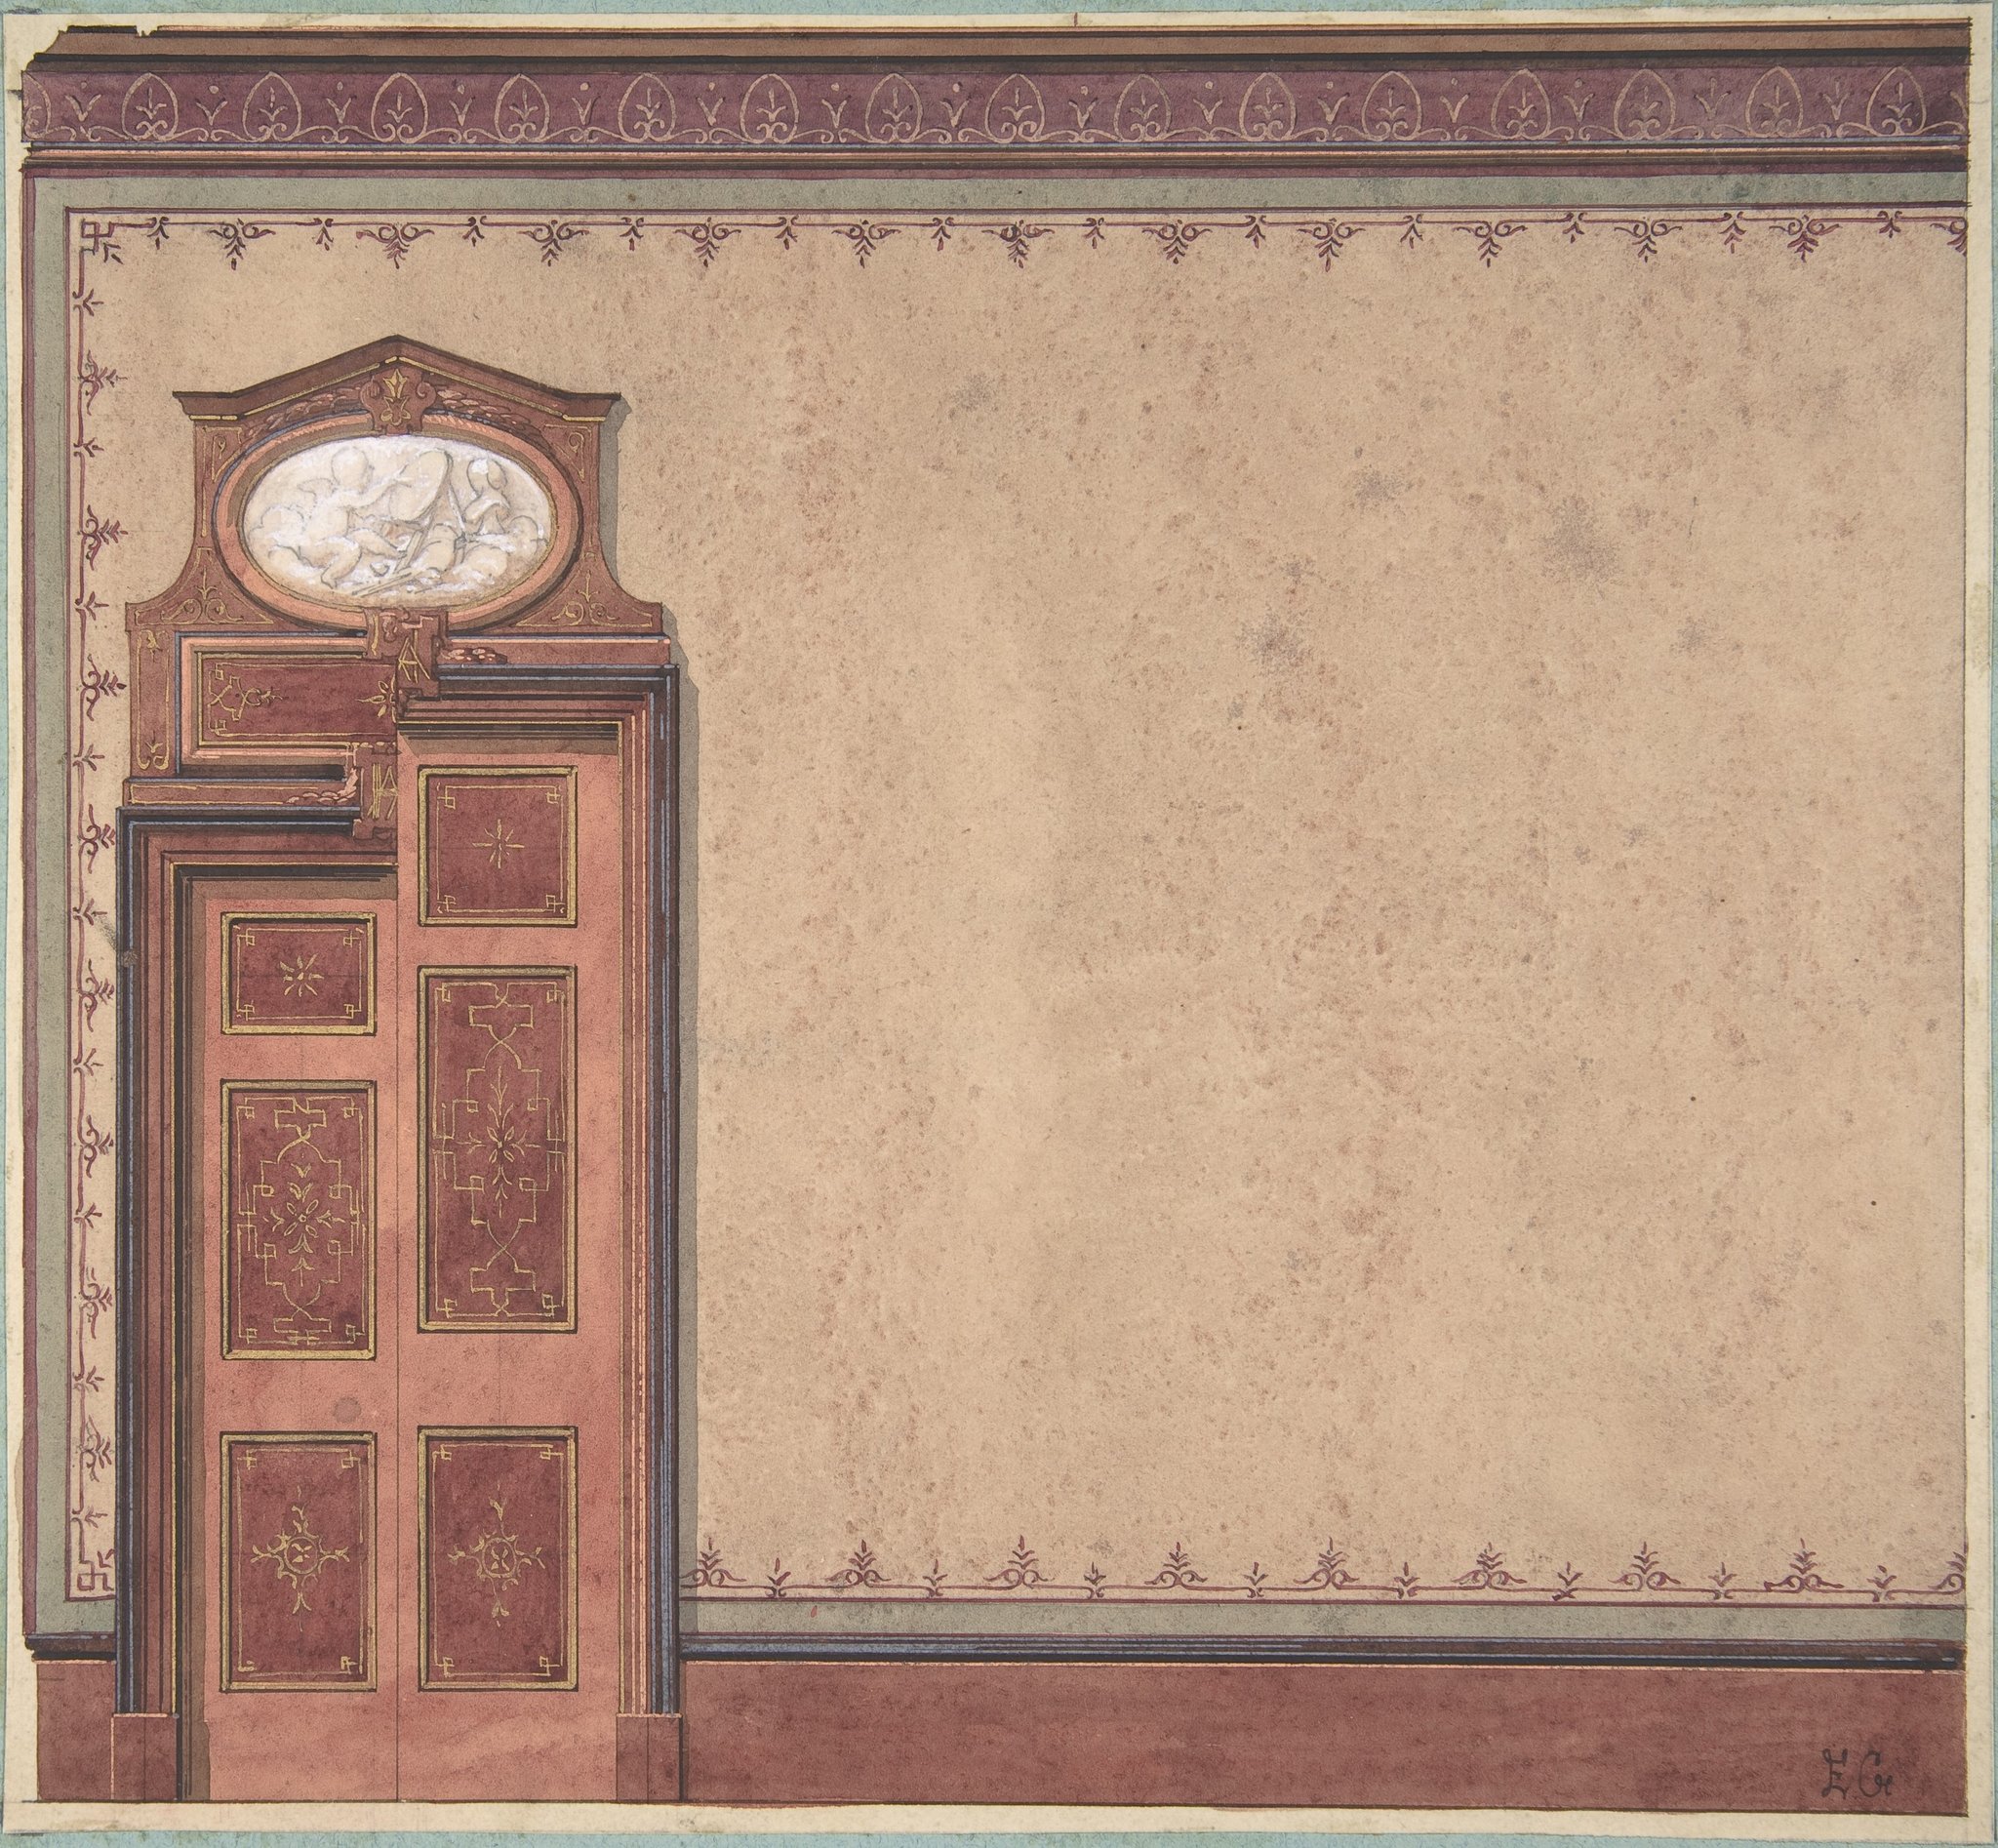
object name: drawing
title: Pompeiian Design for Wall and Doorway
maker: jules-edmond-charles lachaise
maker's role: artist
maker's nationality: french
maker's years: 1897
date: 1851-1900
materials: gilt, gouache, ink, watercolor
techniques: pen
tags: doorways